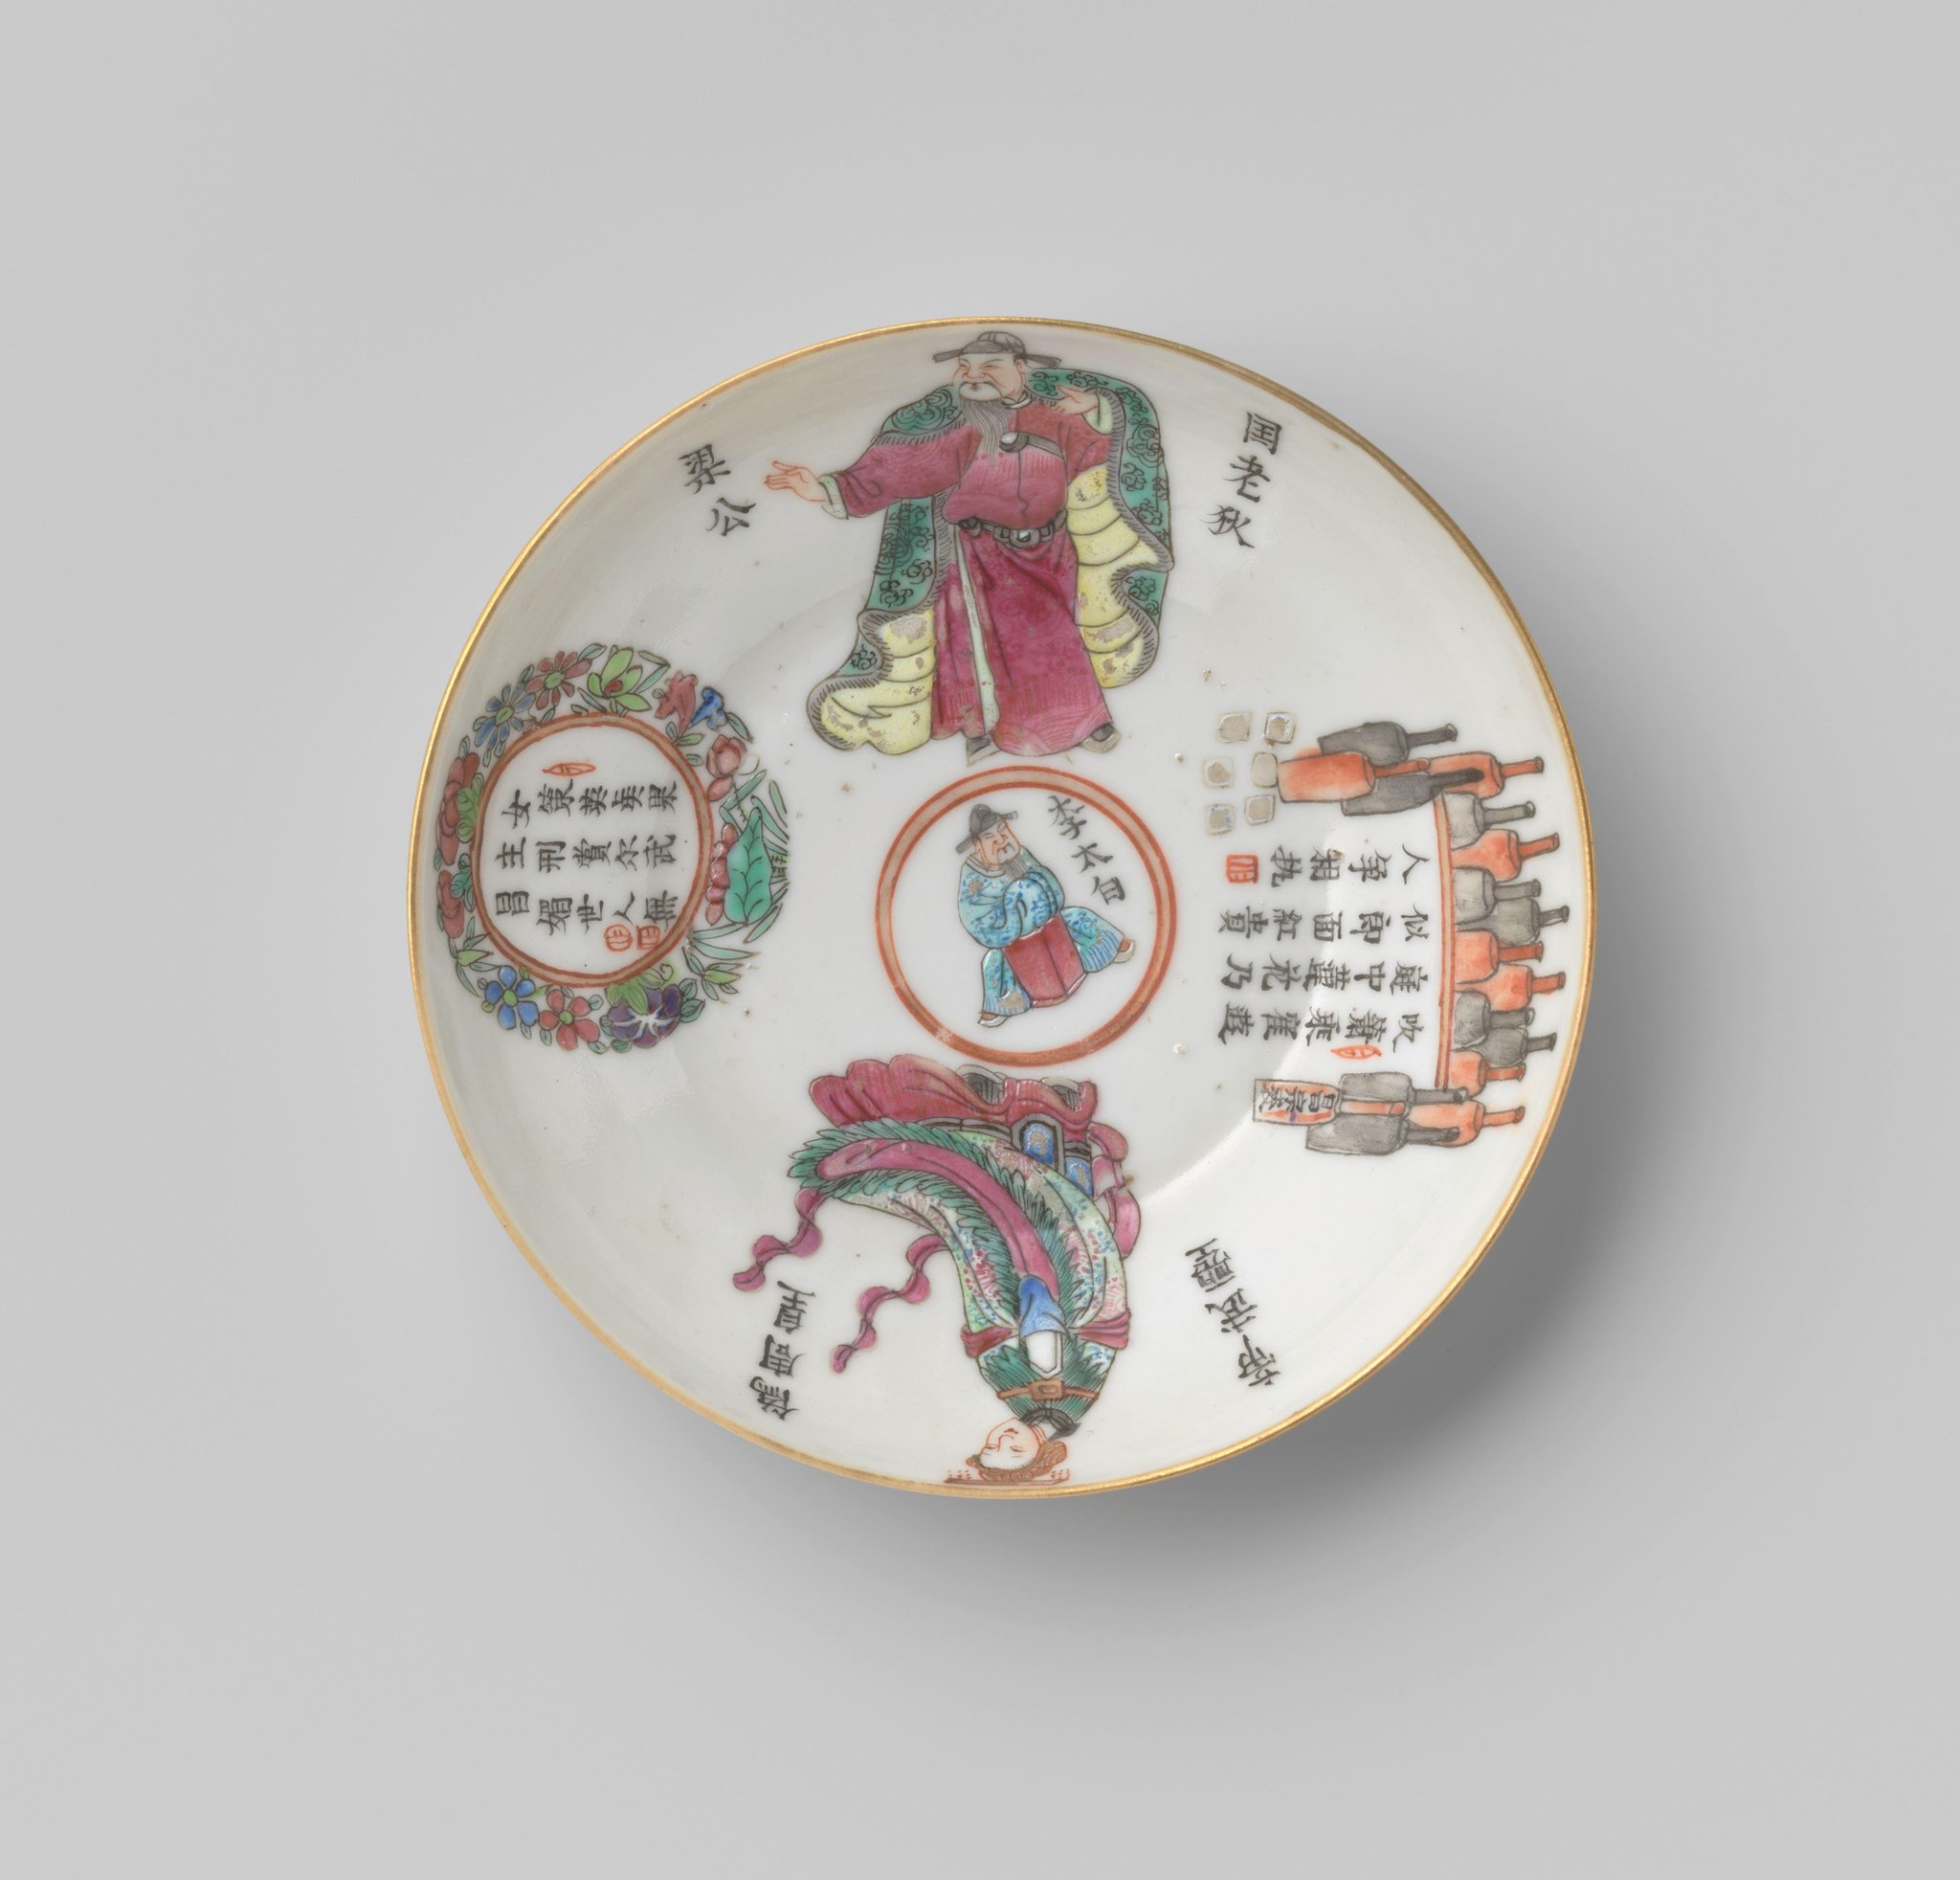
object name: kop en schotel, kop en schotel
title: Saucer with figures, a go-bord and inscriptions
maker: Anonymous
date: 1800-1899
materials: glaze, gold, paint, porcelain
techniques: firing, gilding, turning, vitrification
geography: china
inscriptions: mark: ‘大 清 咸 豐 年 製’, mark: ‘大 清 道 光 年 製’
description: Kop en schotel, met deksels met chinese figuren en karakters in kleuren.